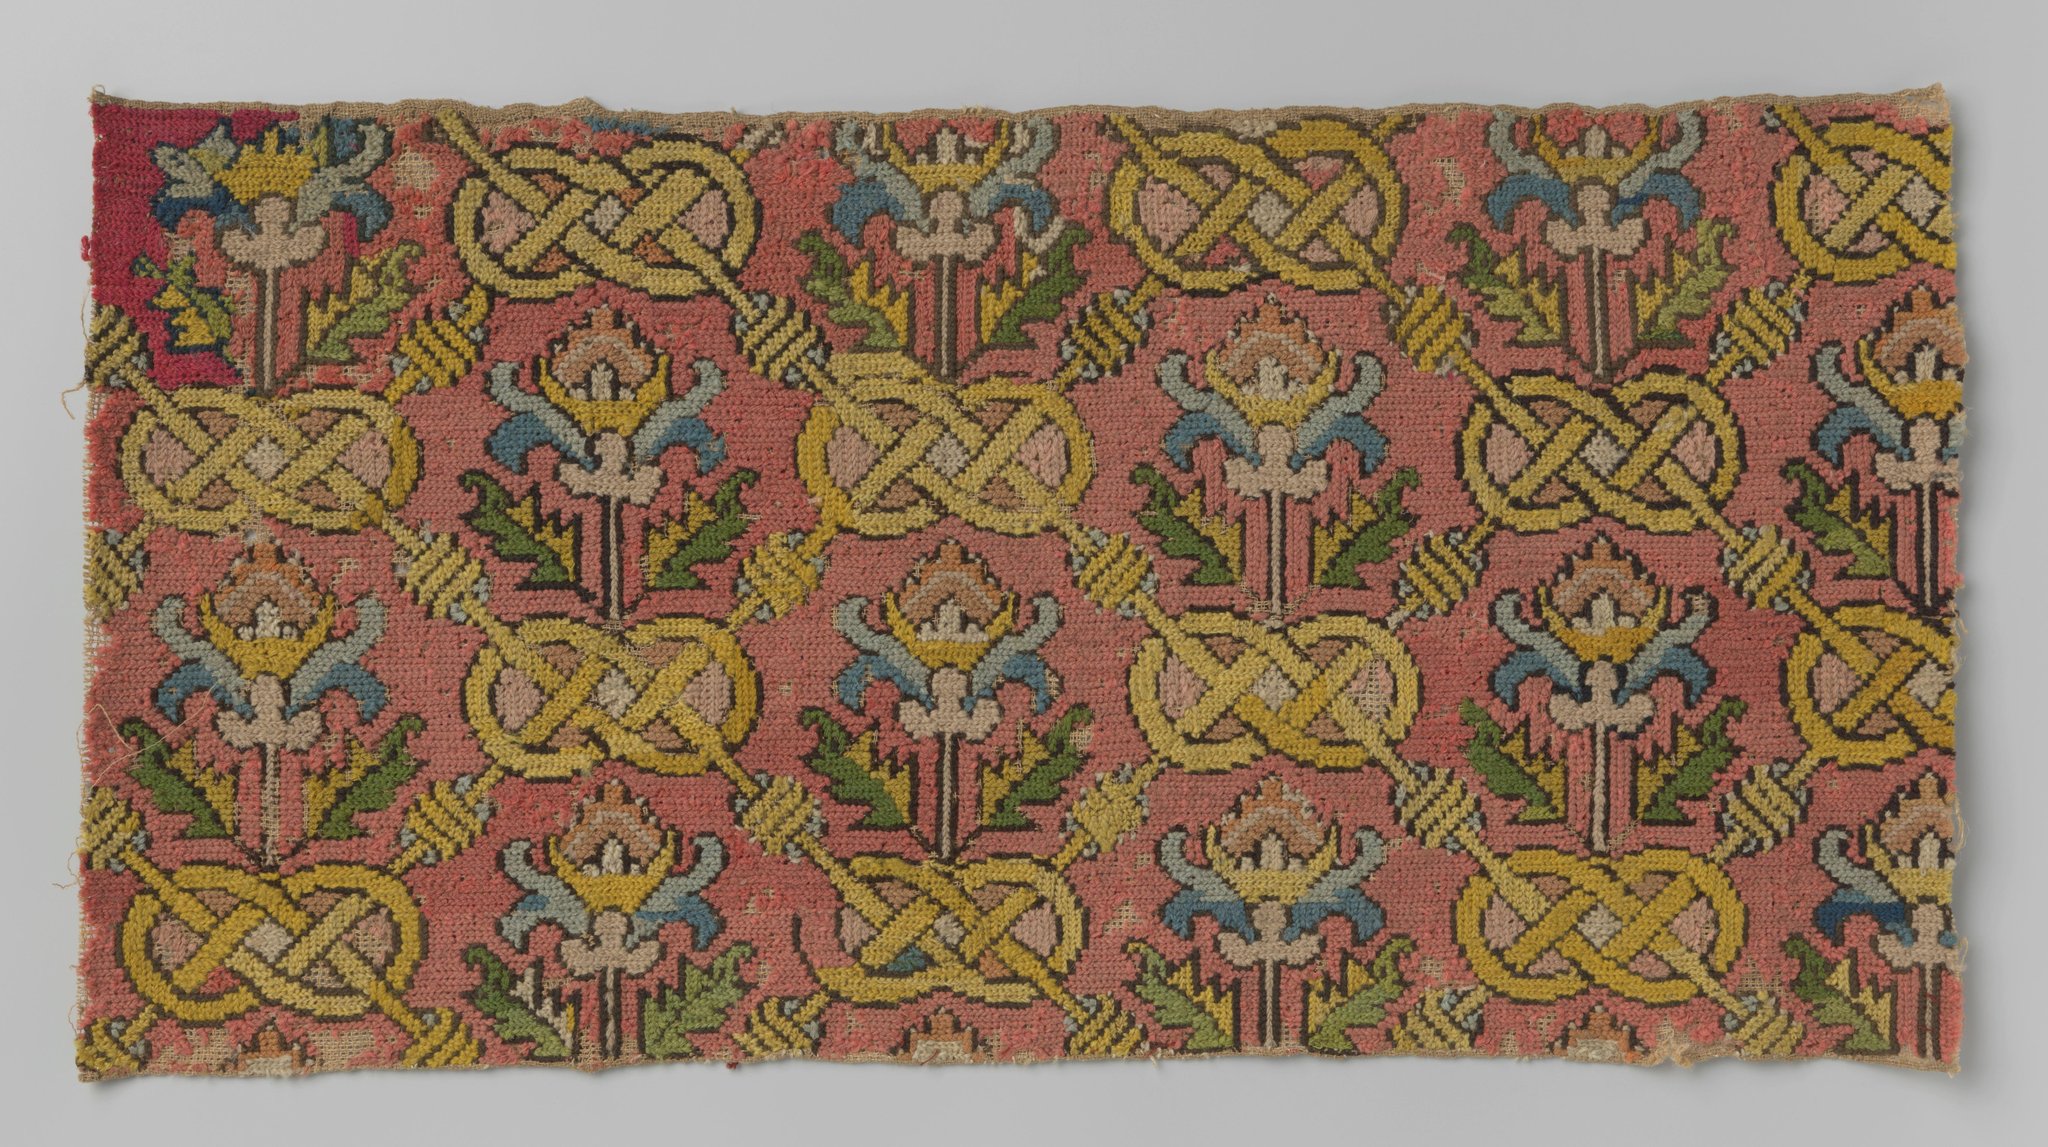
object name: embroidery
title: Werkstuk van borduurwerk op stramien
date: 1700-1800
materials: jute, wool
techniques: embroidered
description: Werkstuk van borduurwerk op stramien. Het werkstuk bestaat uit gele banden die zich tot ruiten kruisen en zich op de kruispunten tot lussen vormen, daartussen een gestileerde tak met een grote bloem en twee bladeren op een rood bewerkte grond.